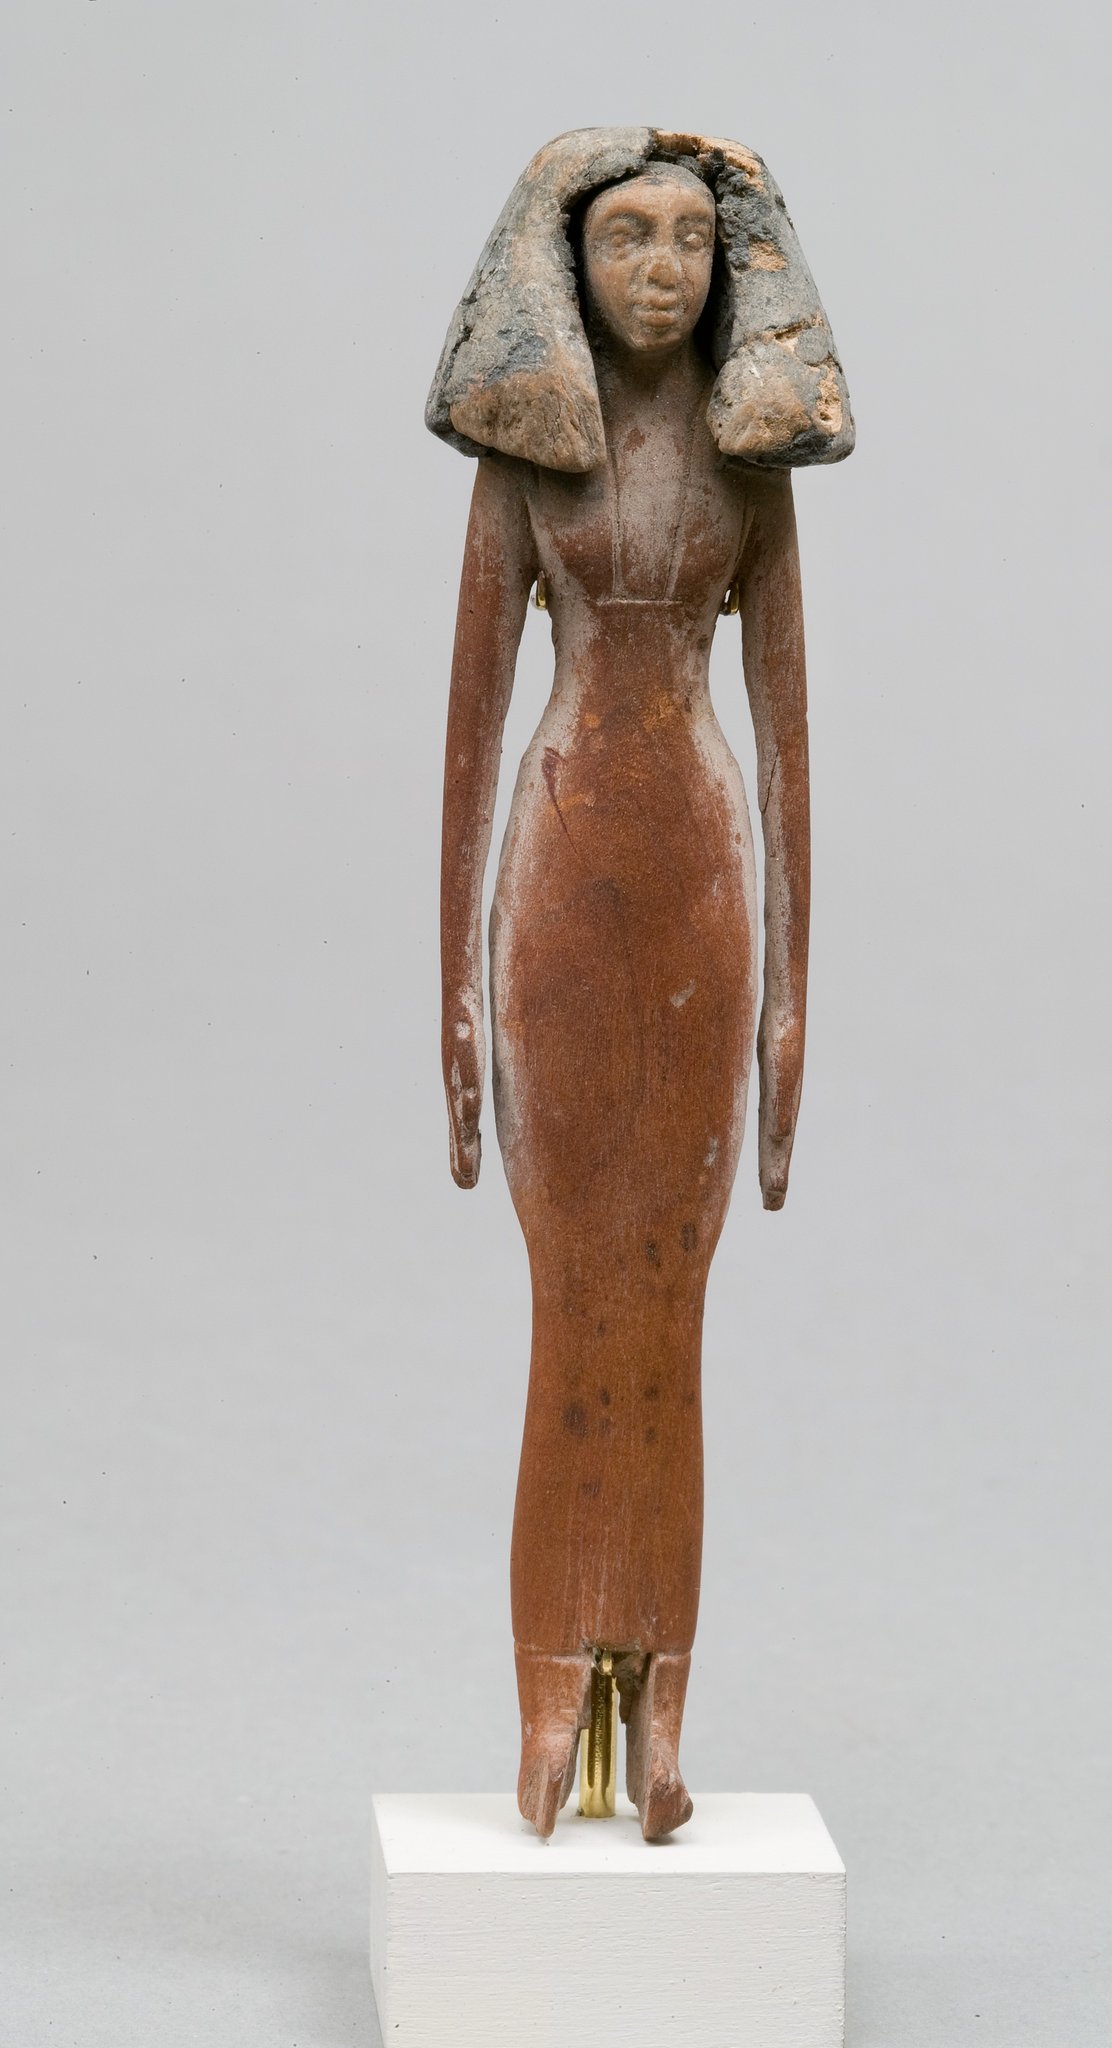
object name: statuette of a woman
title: Statuette of woman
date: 1981-1640 BCE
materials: paint, wood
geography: egypt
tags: women